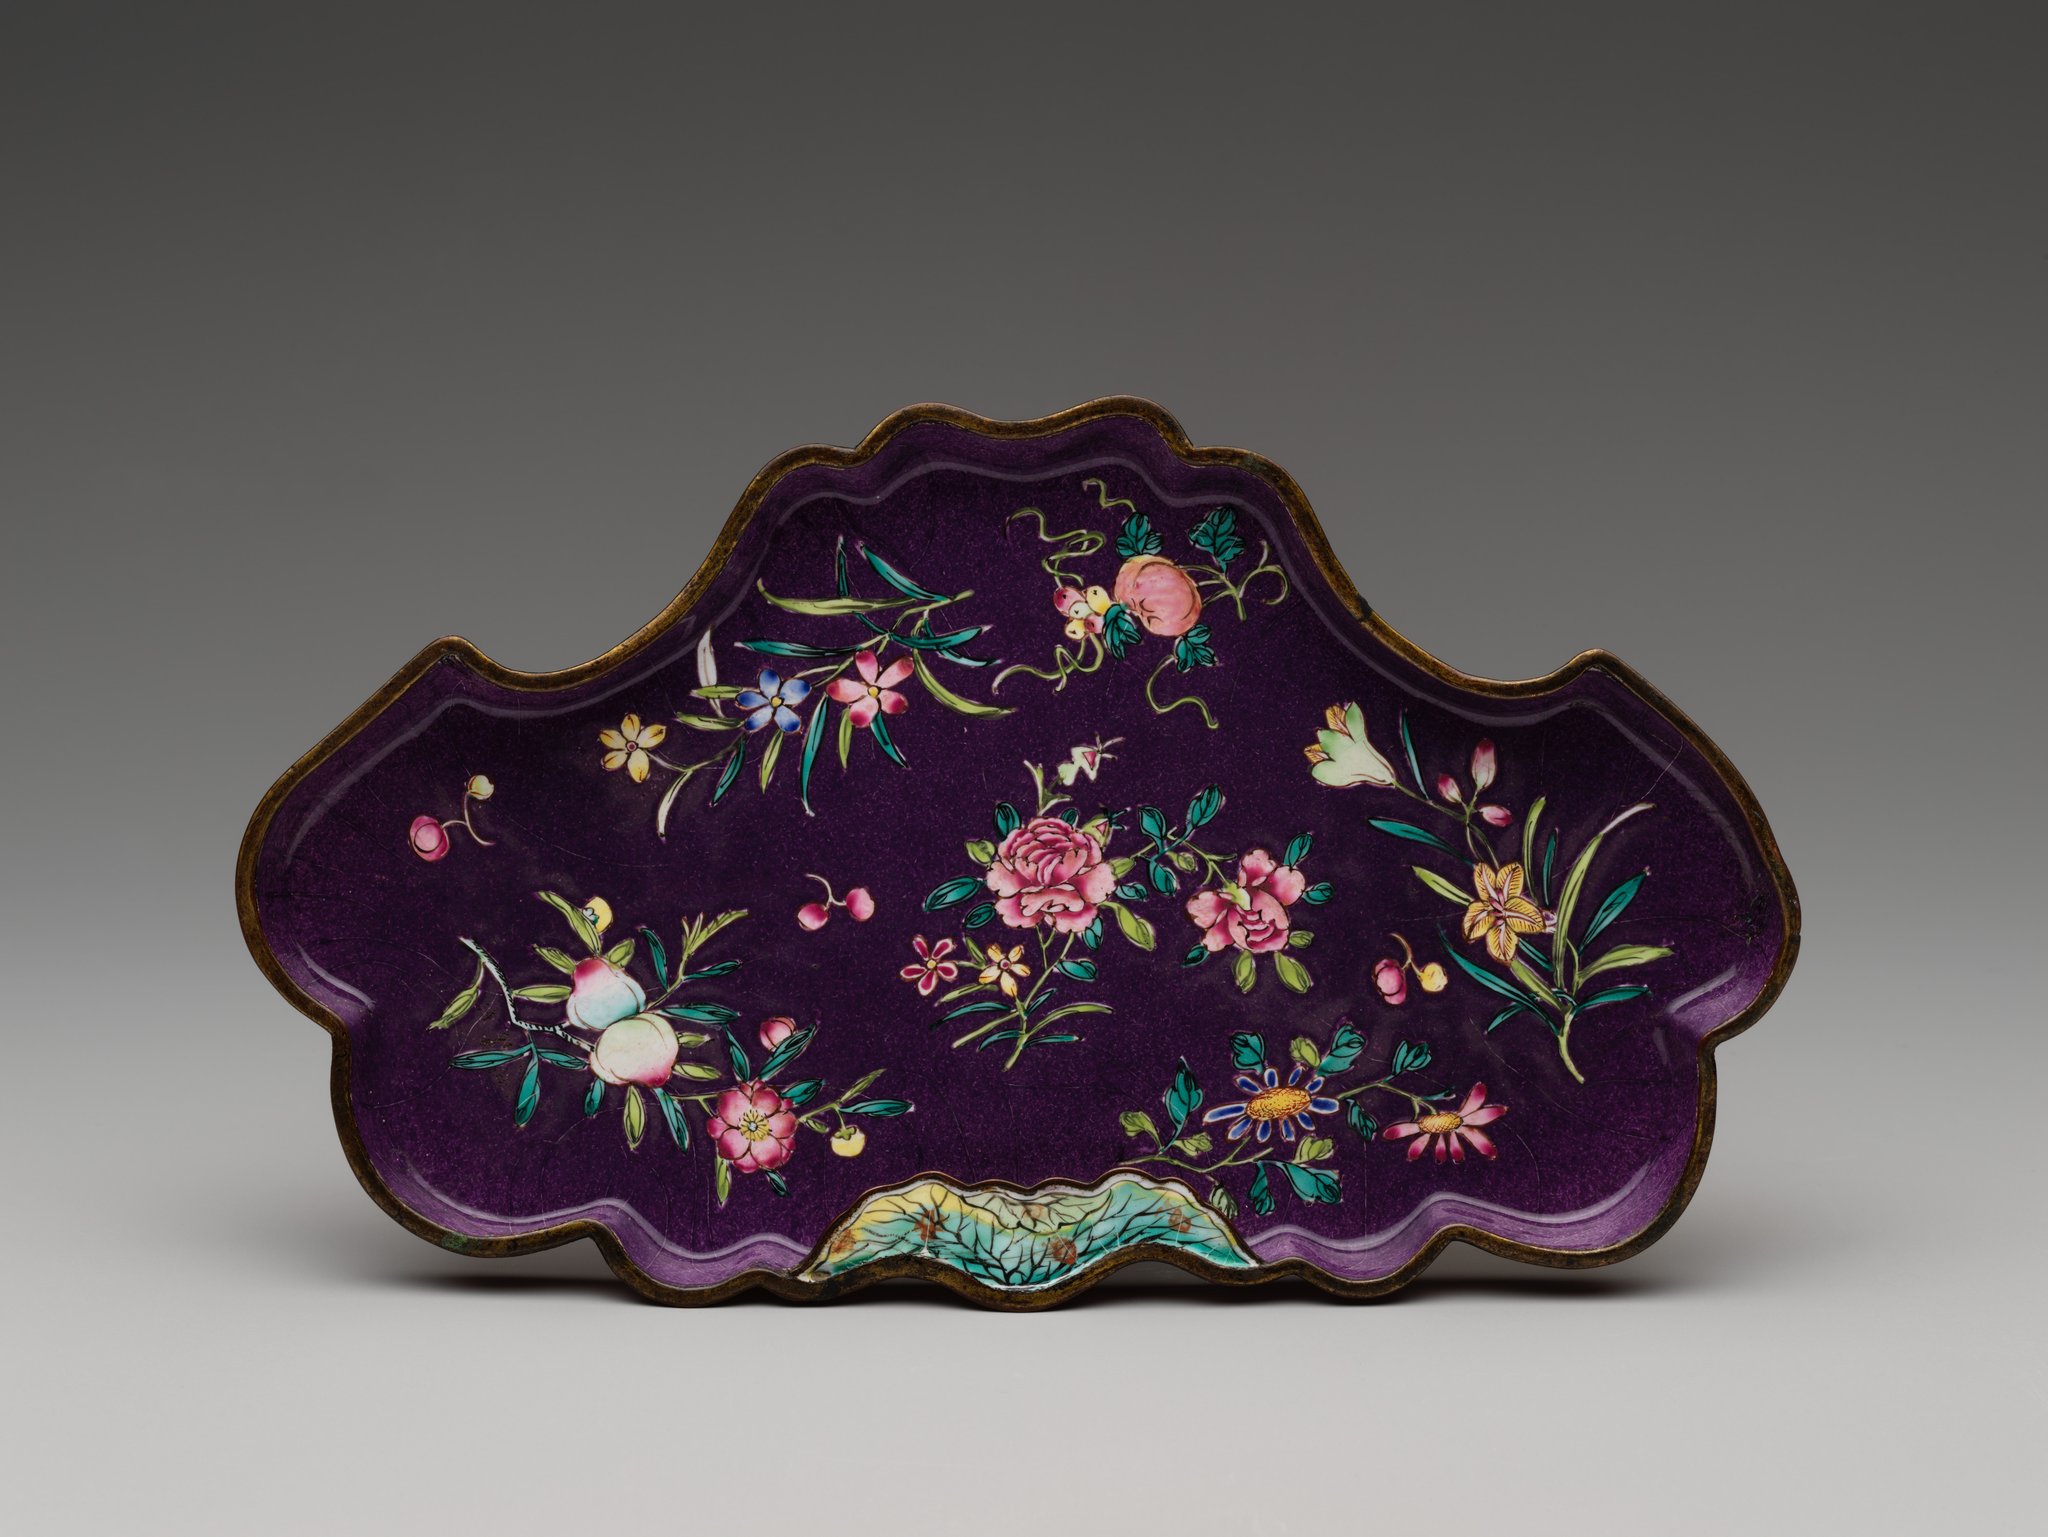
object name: tray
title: Lotus-leaf formed tray with flowers and fruits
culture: chinese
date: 1801-1900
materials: copper alloy, enamel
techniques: painting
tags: flowers